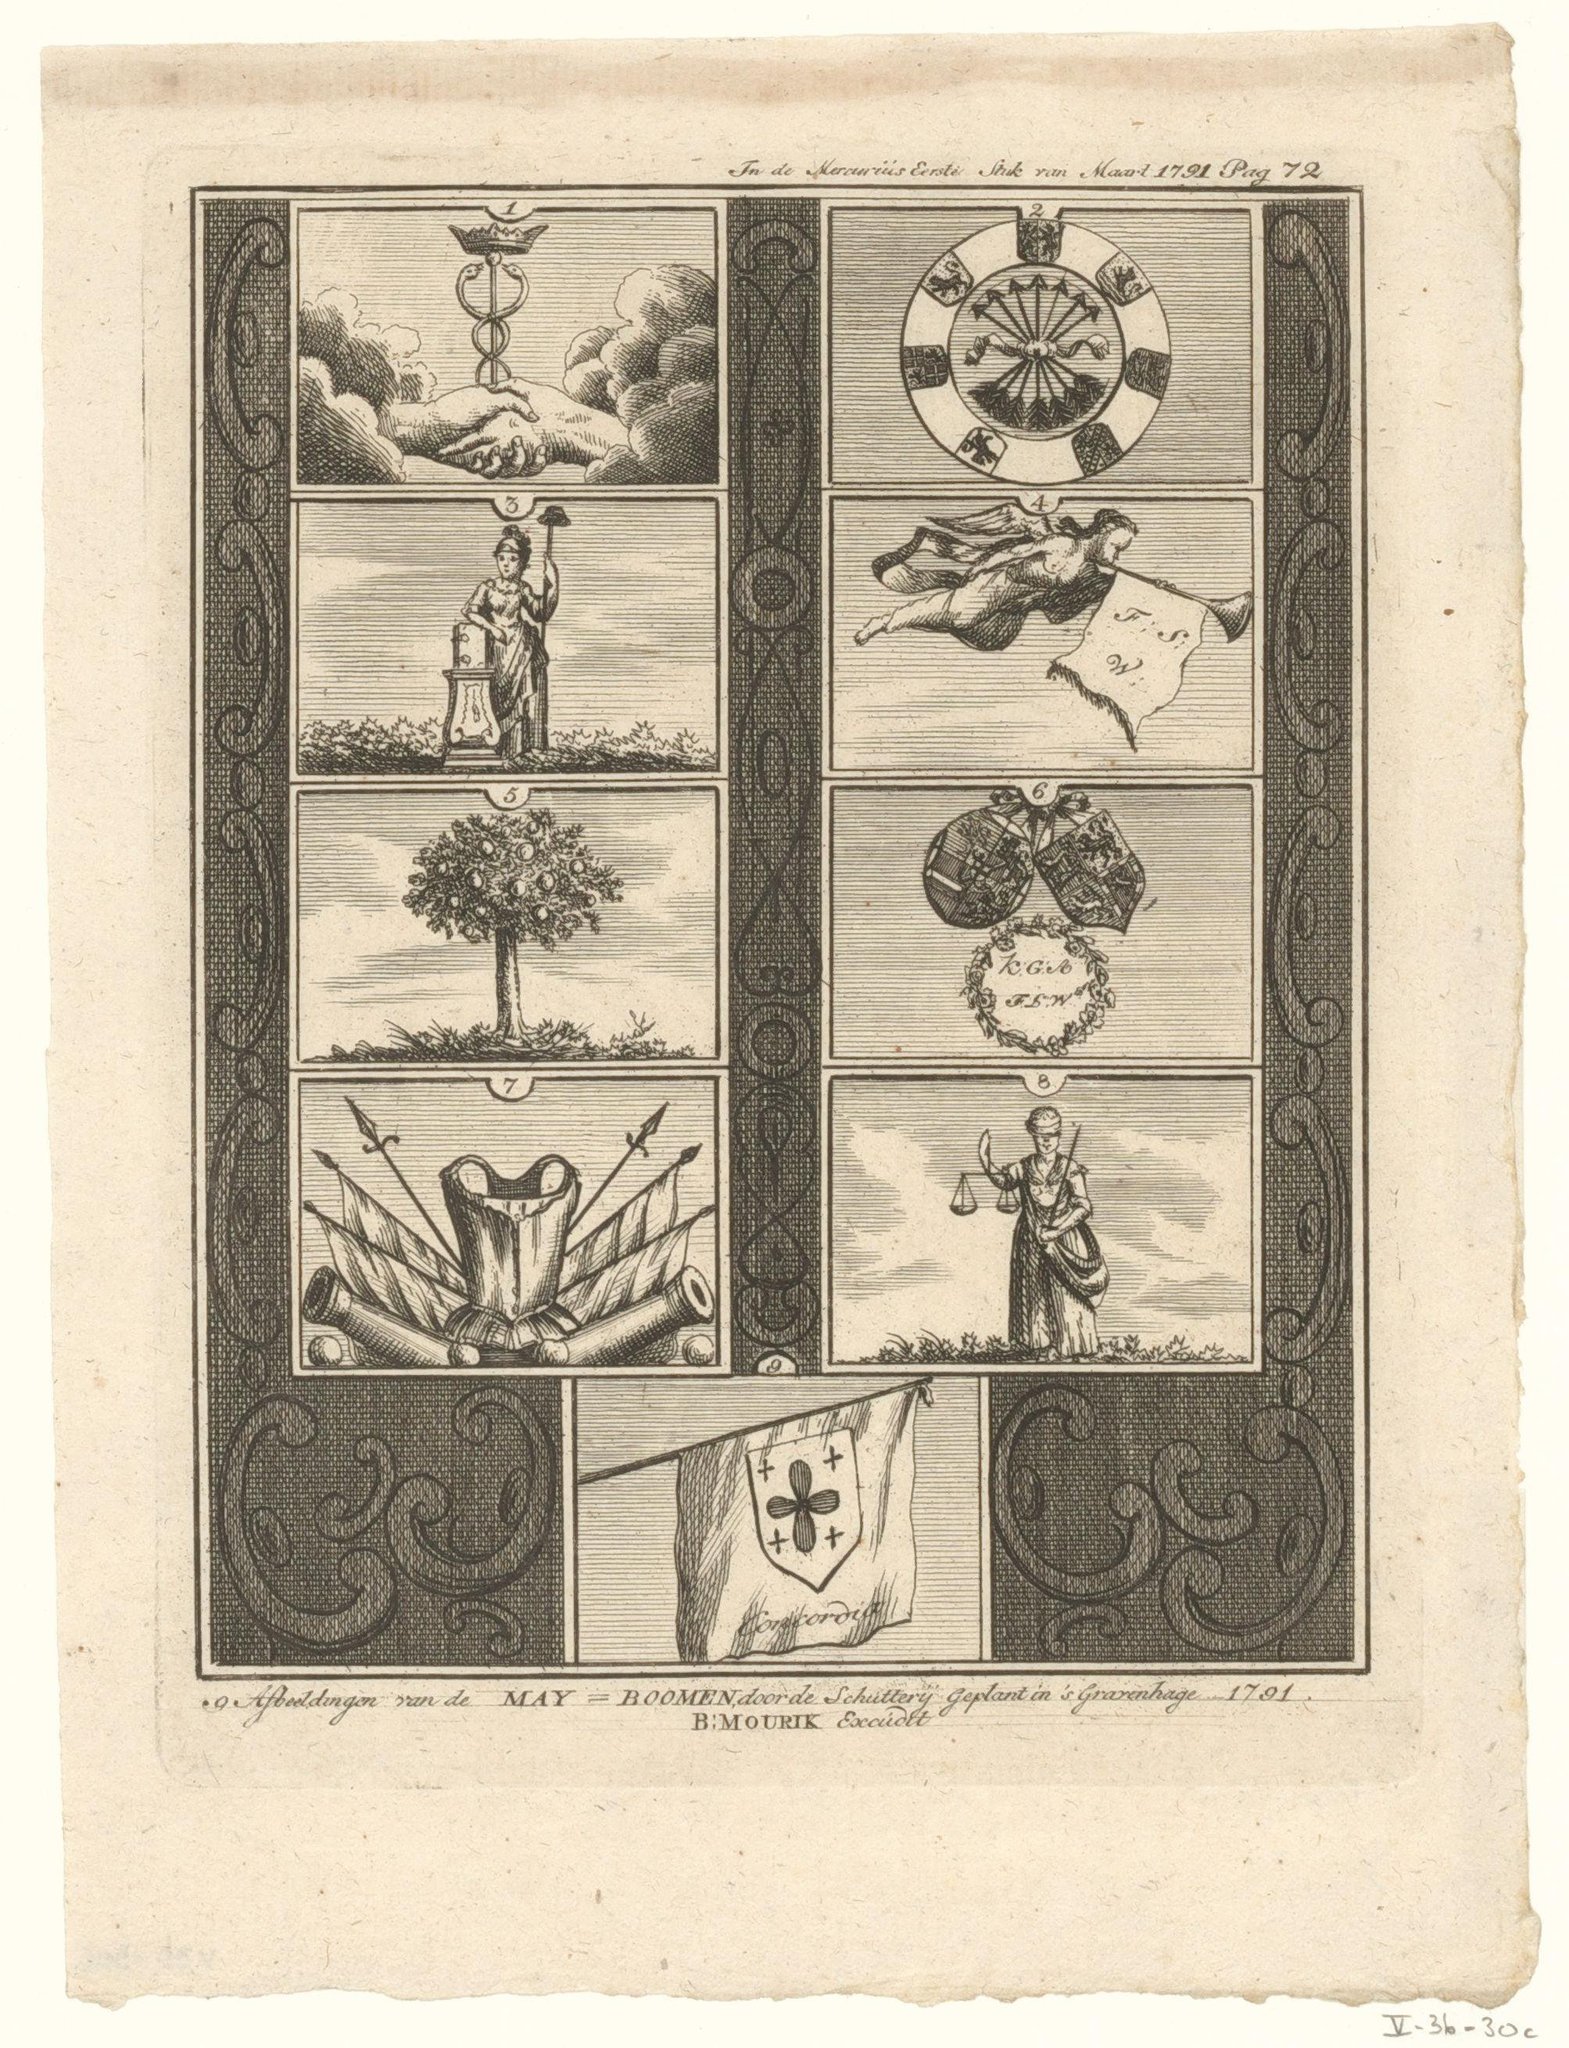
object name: print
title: Meiboom geplant door de Haagse Schutterij, 1791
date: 1703-1791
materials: paper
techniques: engraving, etching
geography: amsterdam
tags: maypole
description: Tien genummerde afbeeldingen in twee rijen van vijf. Rechtsboven genummerd: In de Mercurius Eerste Stuk van Maart 1791. Pag. 72. Onderwerpsrubrieken binnen de Atlas Zeden en Gewoonten: Krijgswezen, Schutterij, Meiboomen.